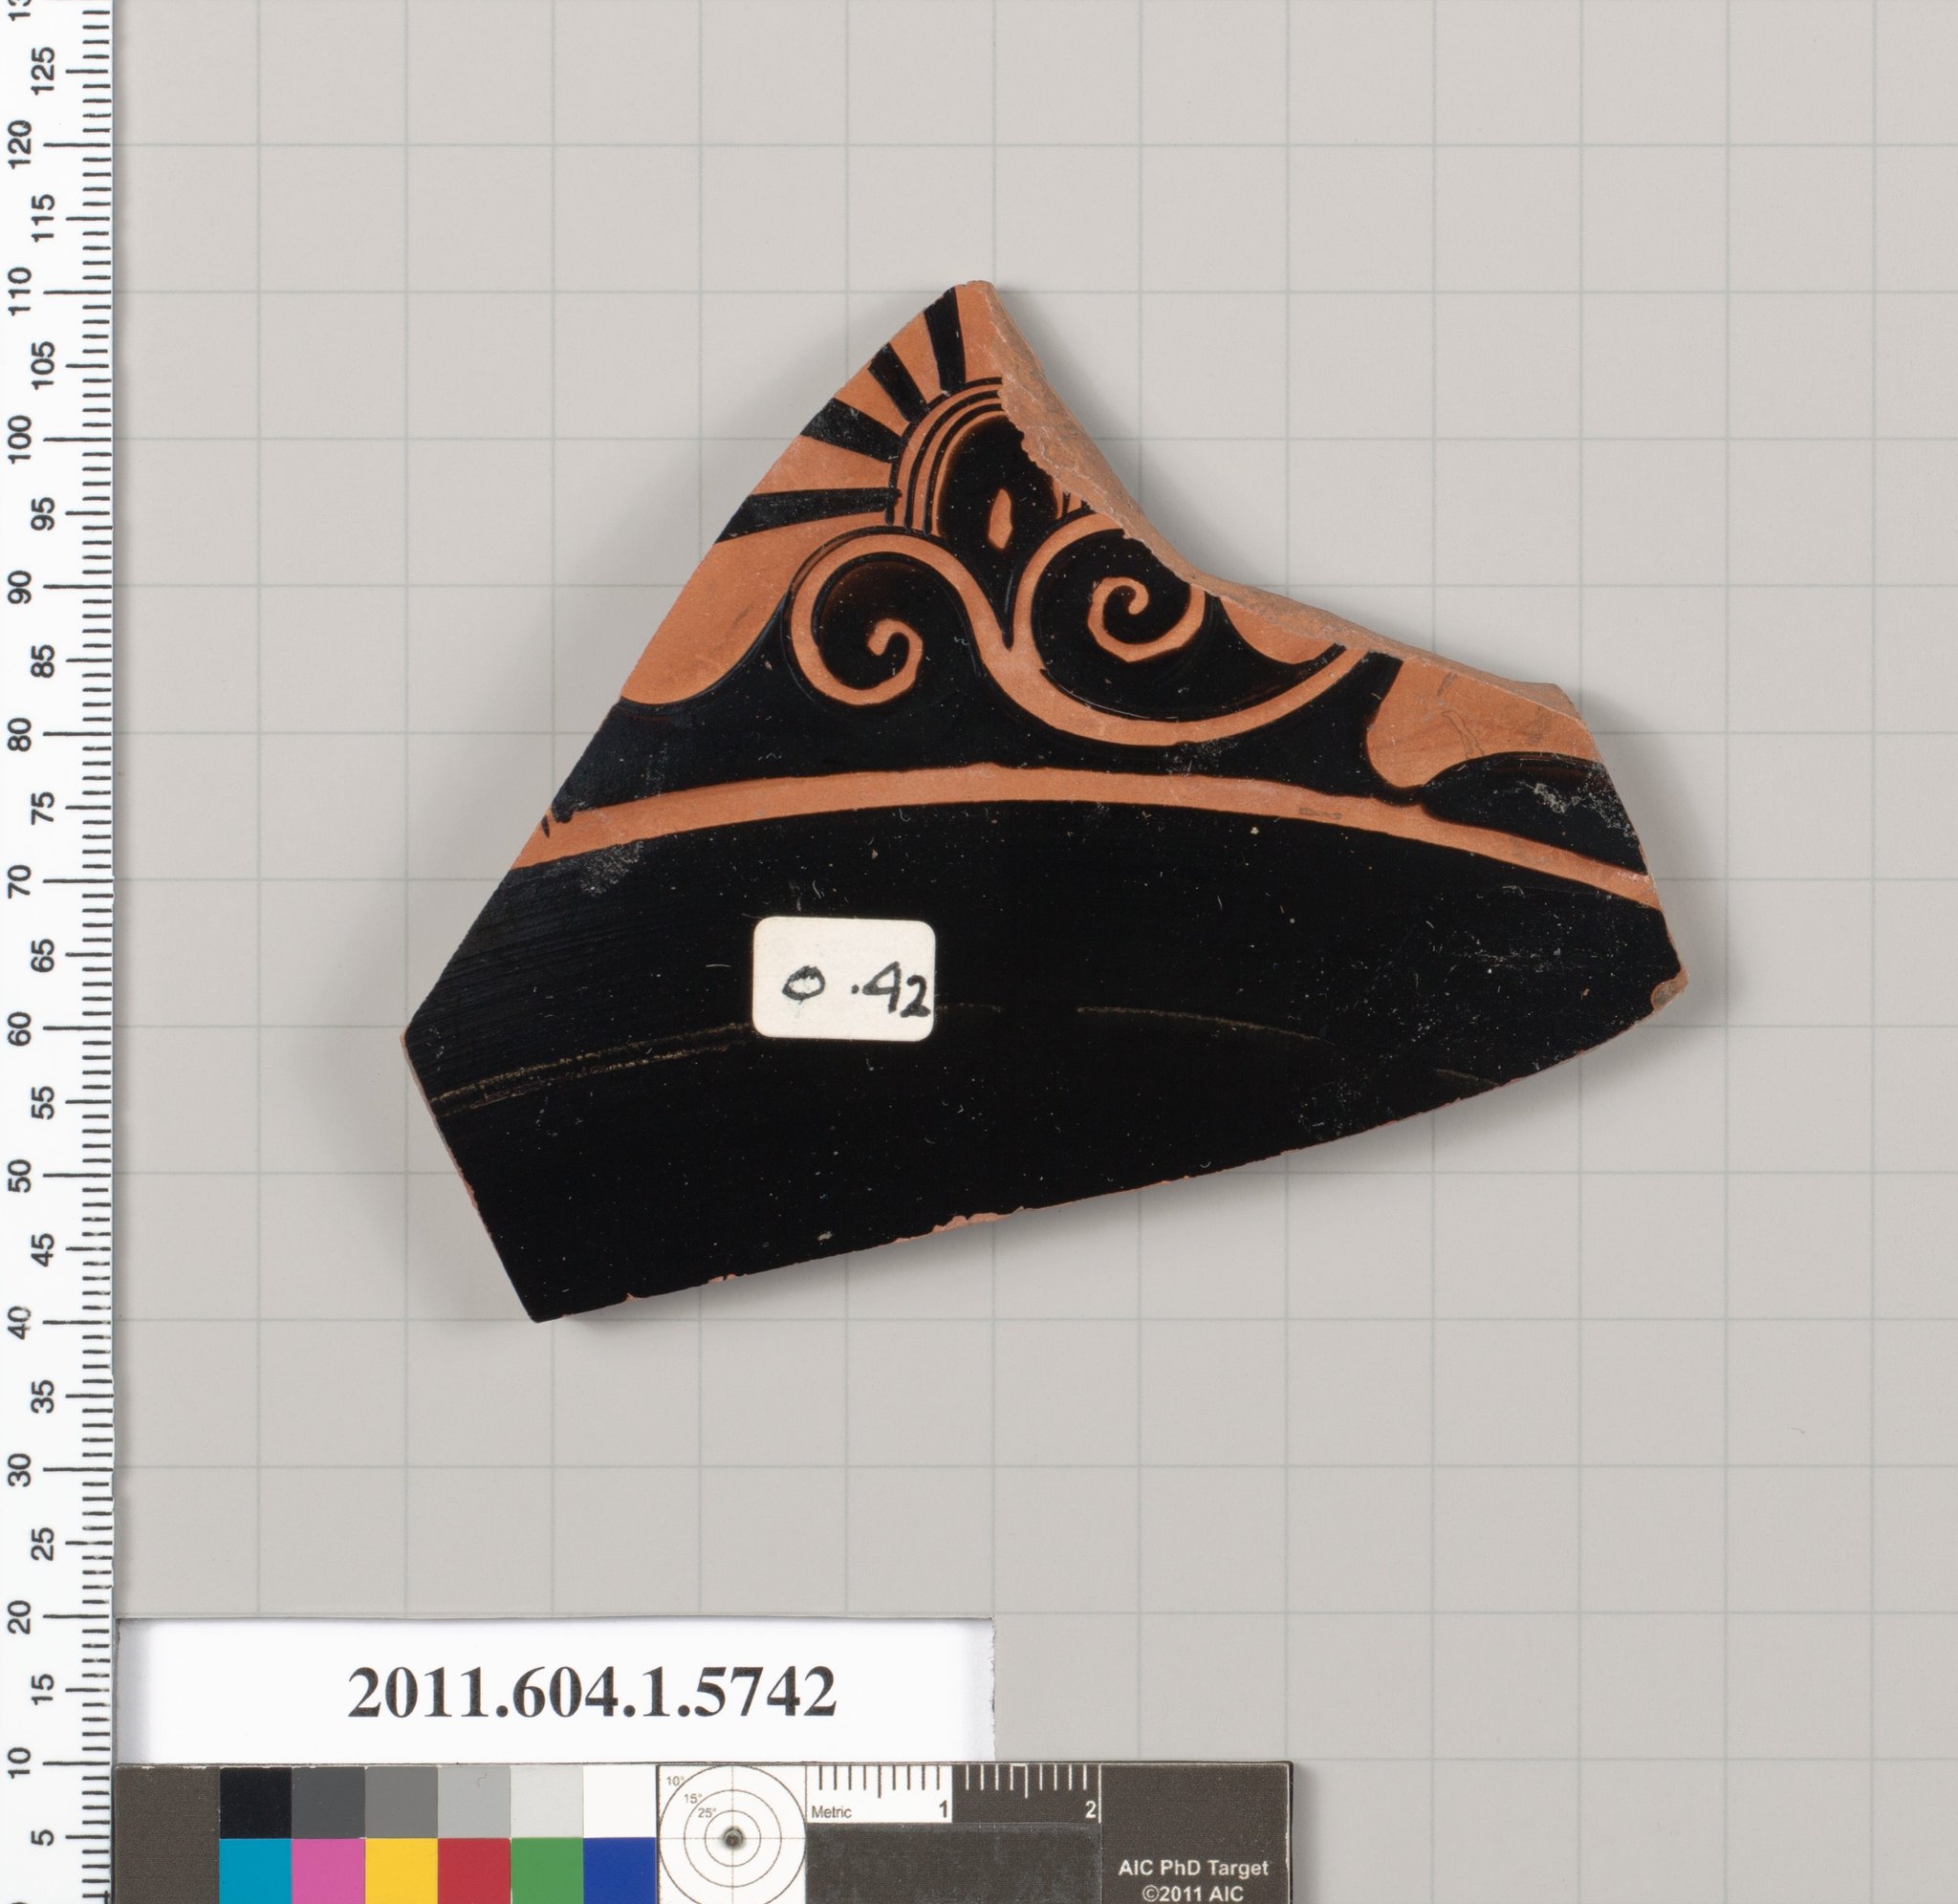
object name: kylix fragment, eye cup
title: Terracotta fragment of a kylix: eye-cup (drinking cup)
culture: greek, attic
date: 525-510 BCE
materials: terracotta